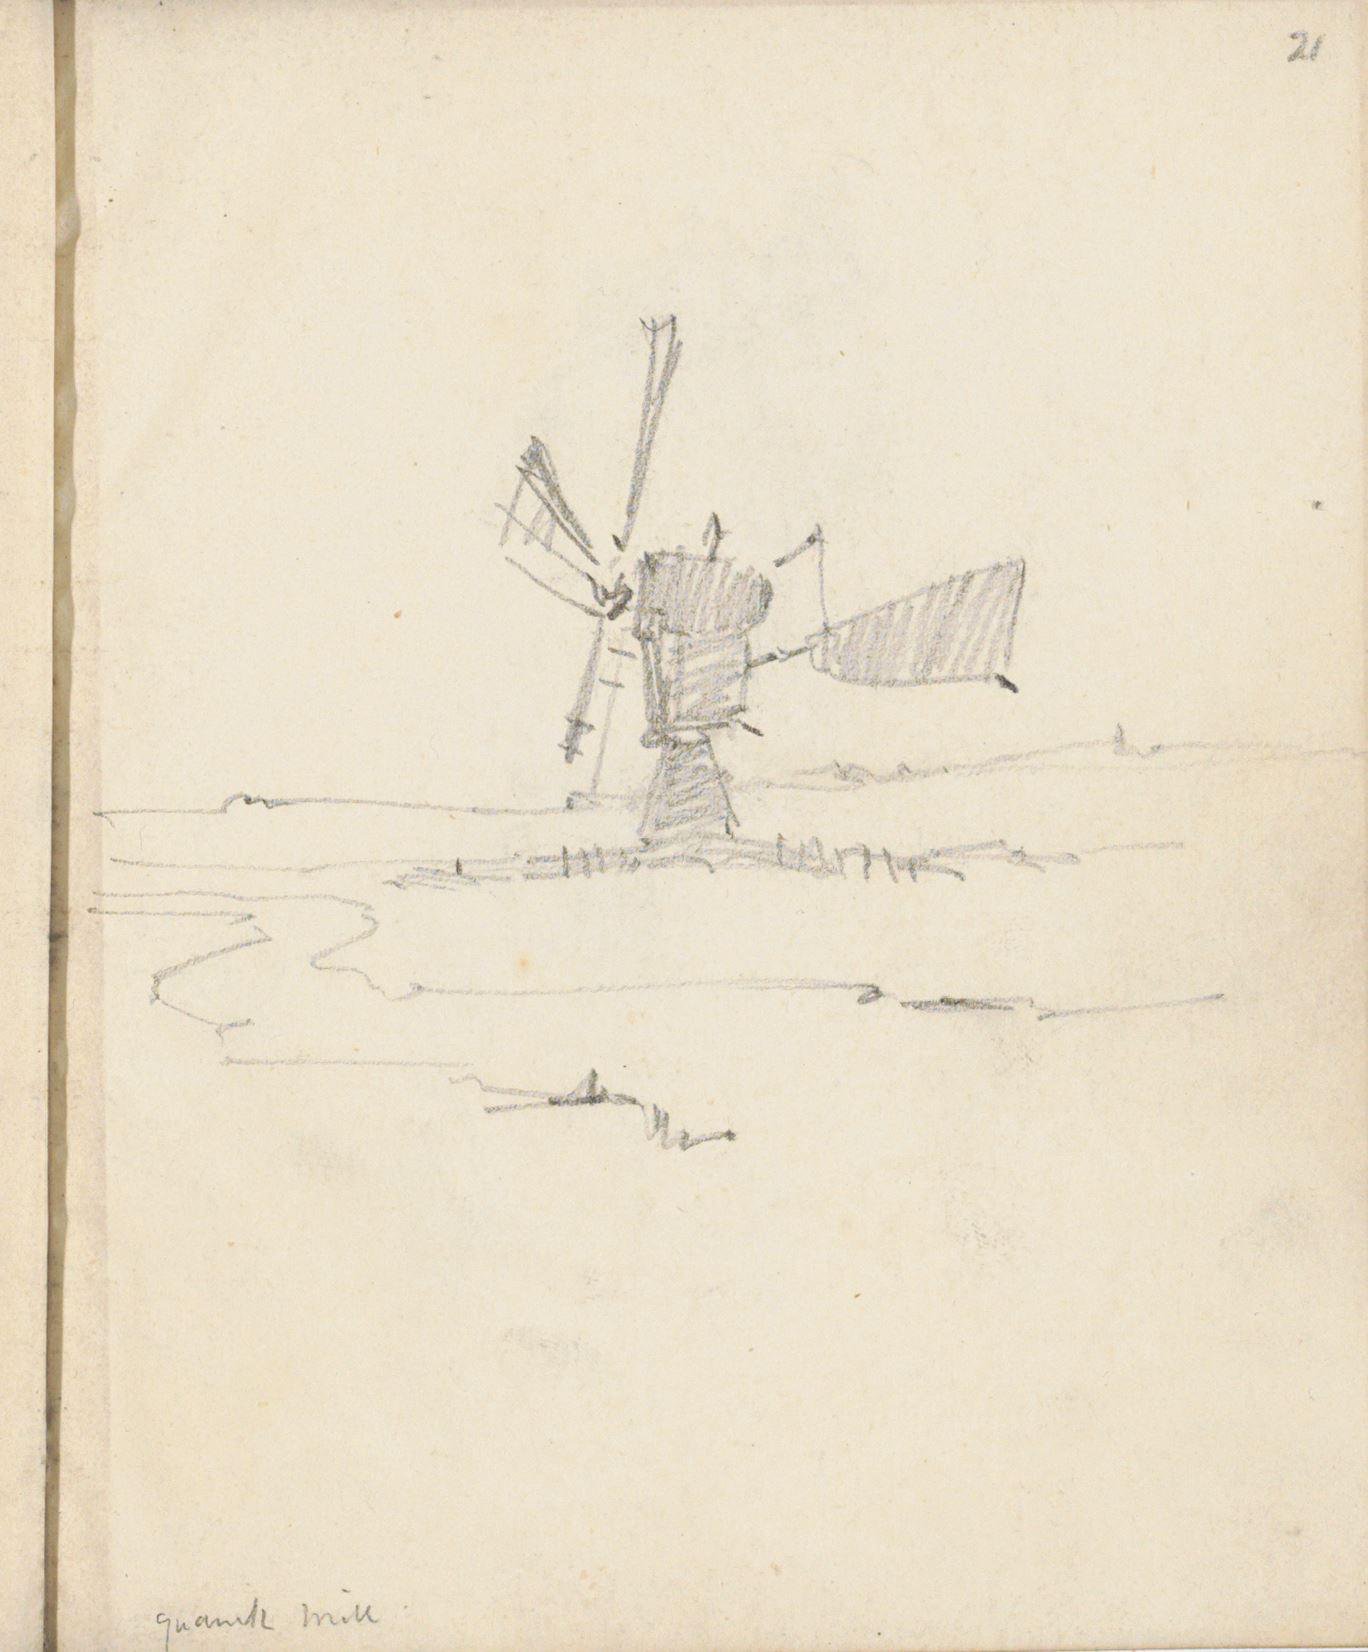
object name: sketchbook leaf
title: Molen in een landschap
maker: alfred william rich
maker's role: draughtsman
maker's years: 1856-1921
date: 1892-1893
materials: paper, pencil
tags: windmill in landscape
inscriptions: annotation: ‘quartz mill’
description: Blad 21 recto uit een schetsboek met 86 bladen.